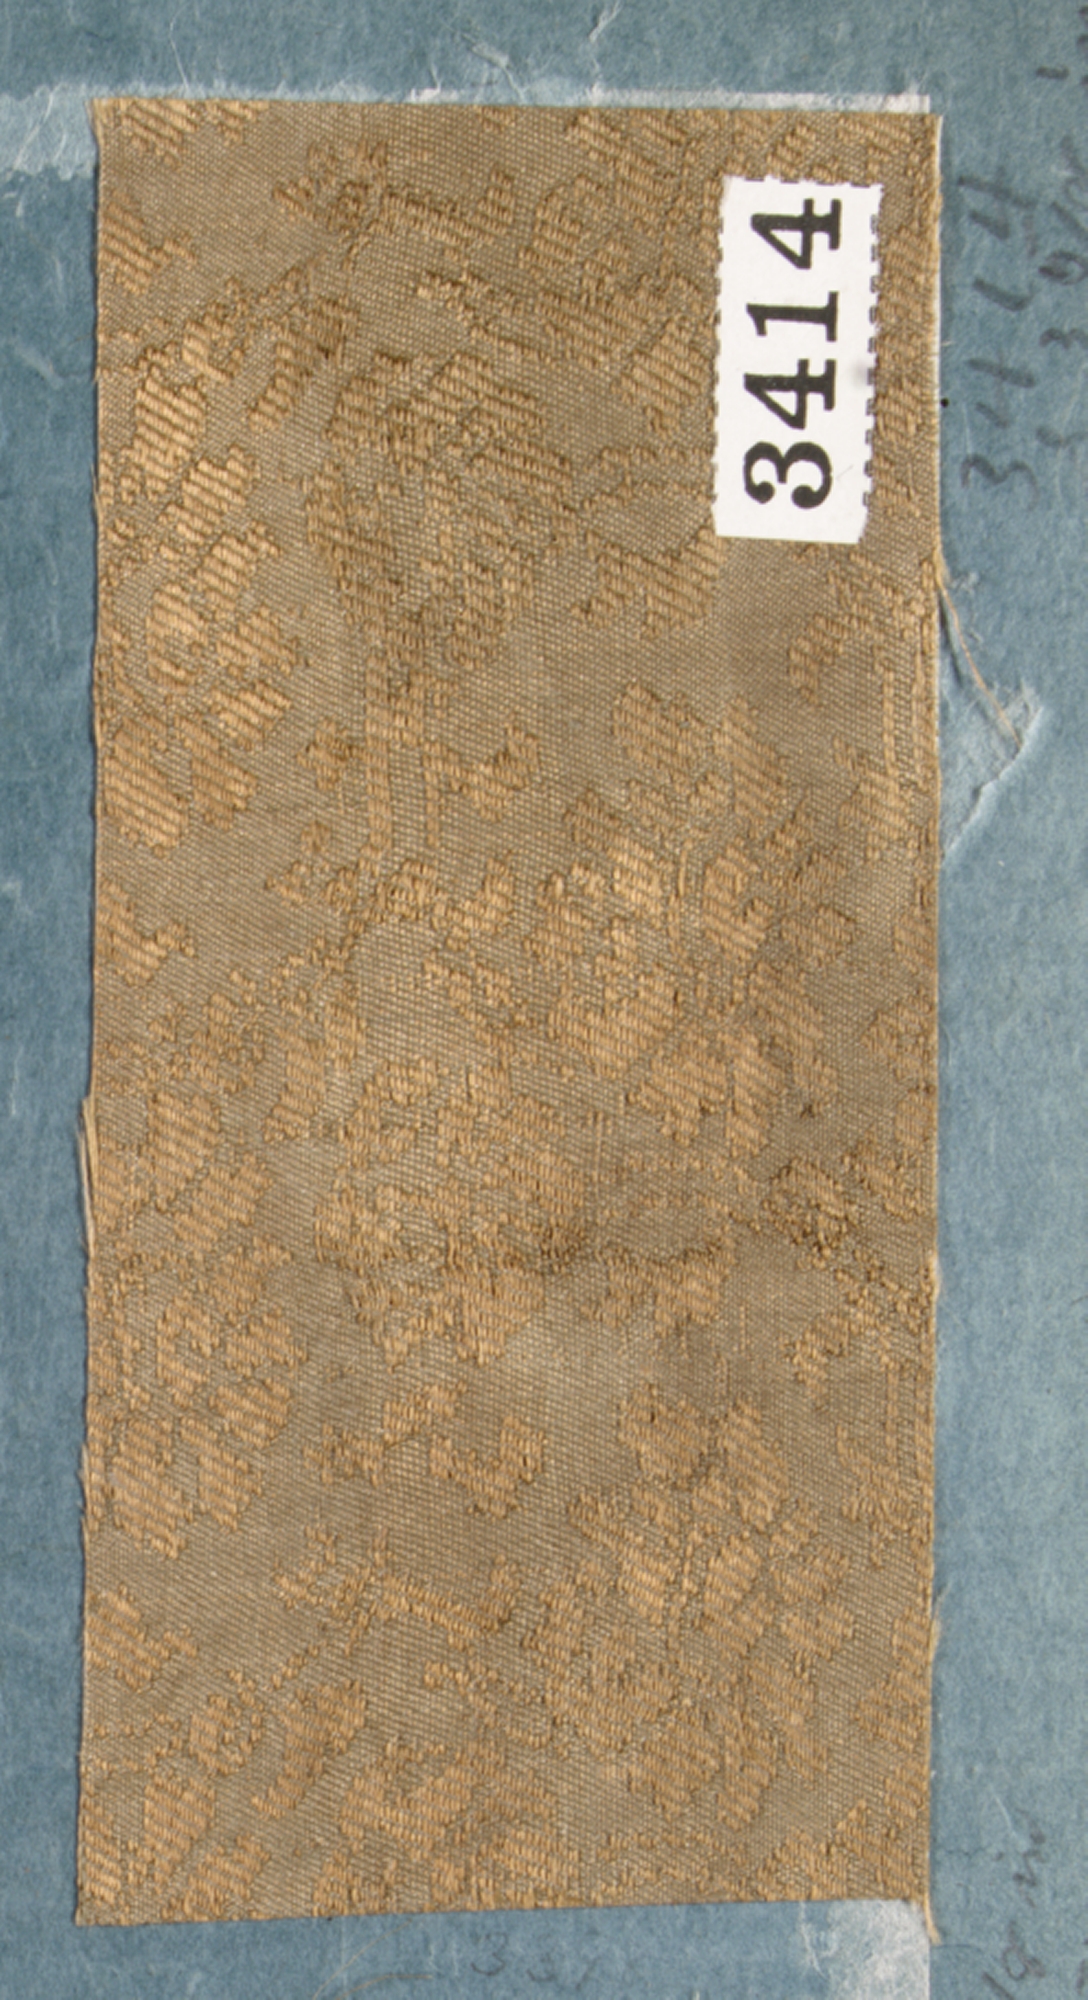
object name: textile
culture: japanese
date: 1801-1900